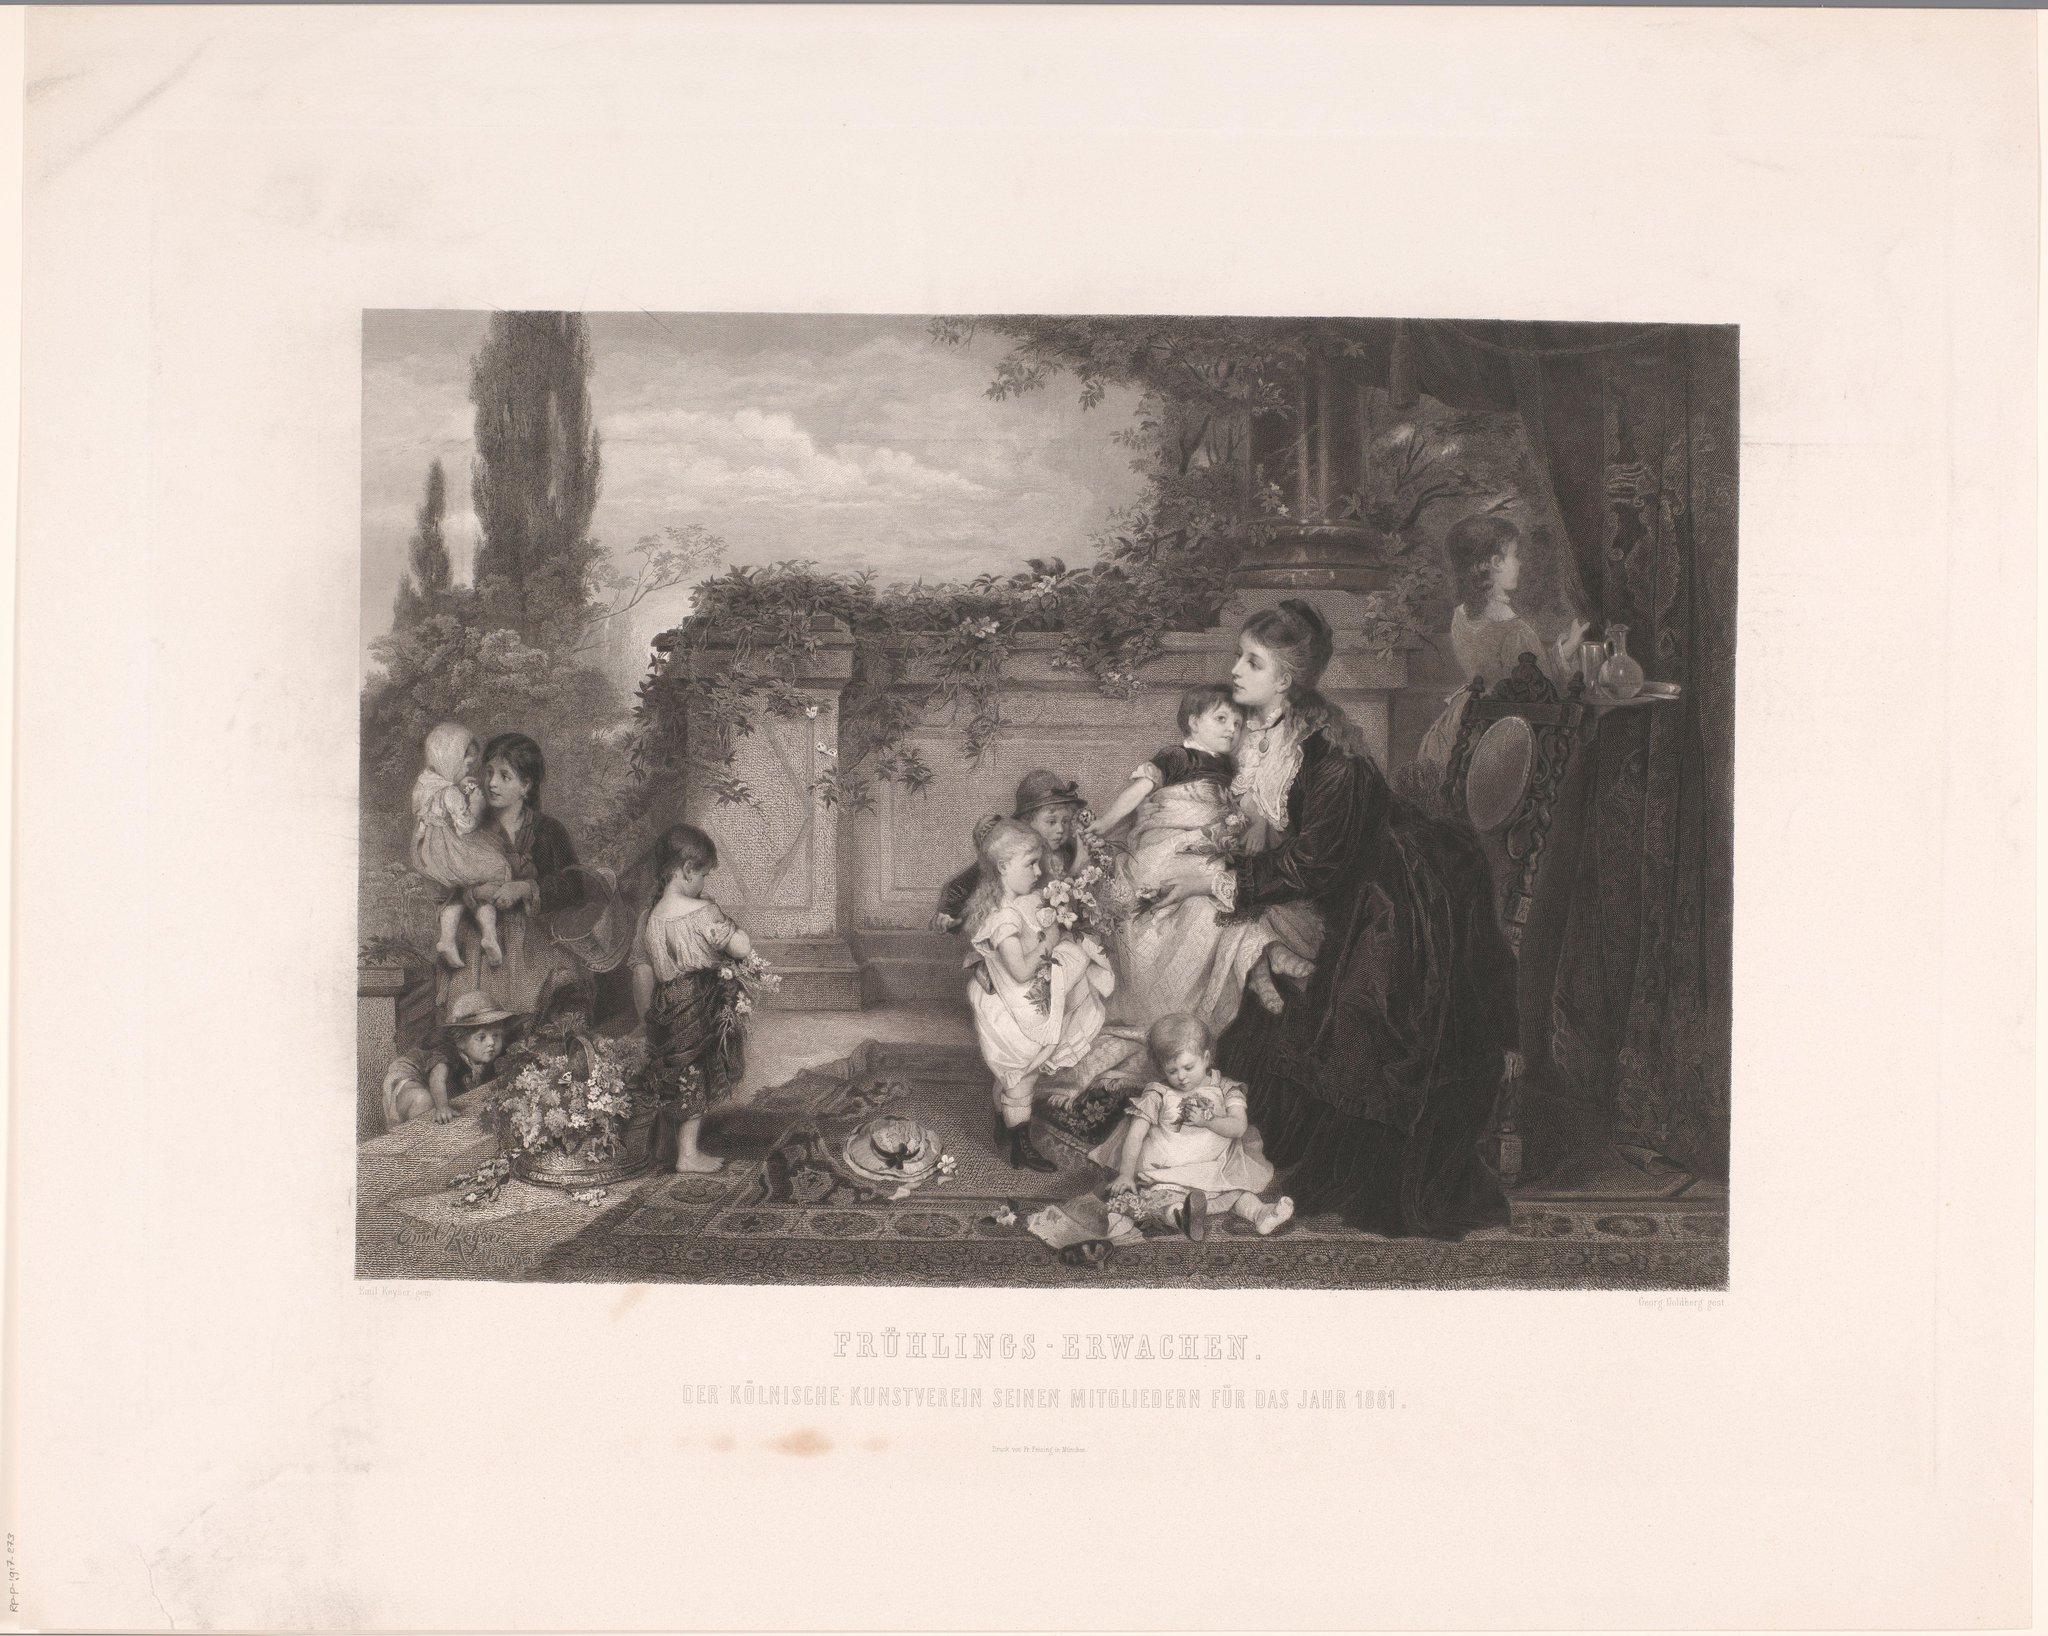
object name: print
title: Frühlings-Erwachen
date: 1881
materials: paper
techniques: etching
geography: munich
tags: cut flowers; nosegay, bunch of flowers, spring, 'ver'; 'primavera' (ripa), mother and child(ren), woman and child(ren) (family group)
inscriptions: collector's mark: Lugt 2228